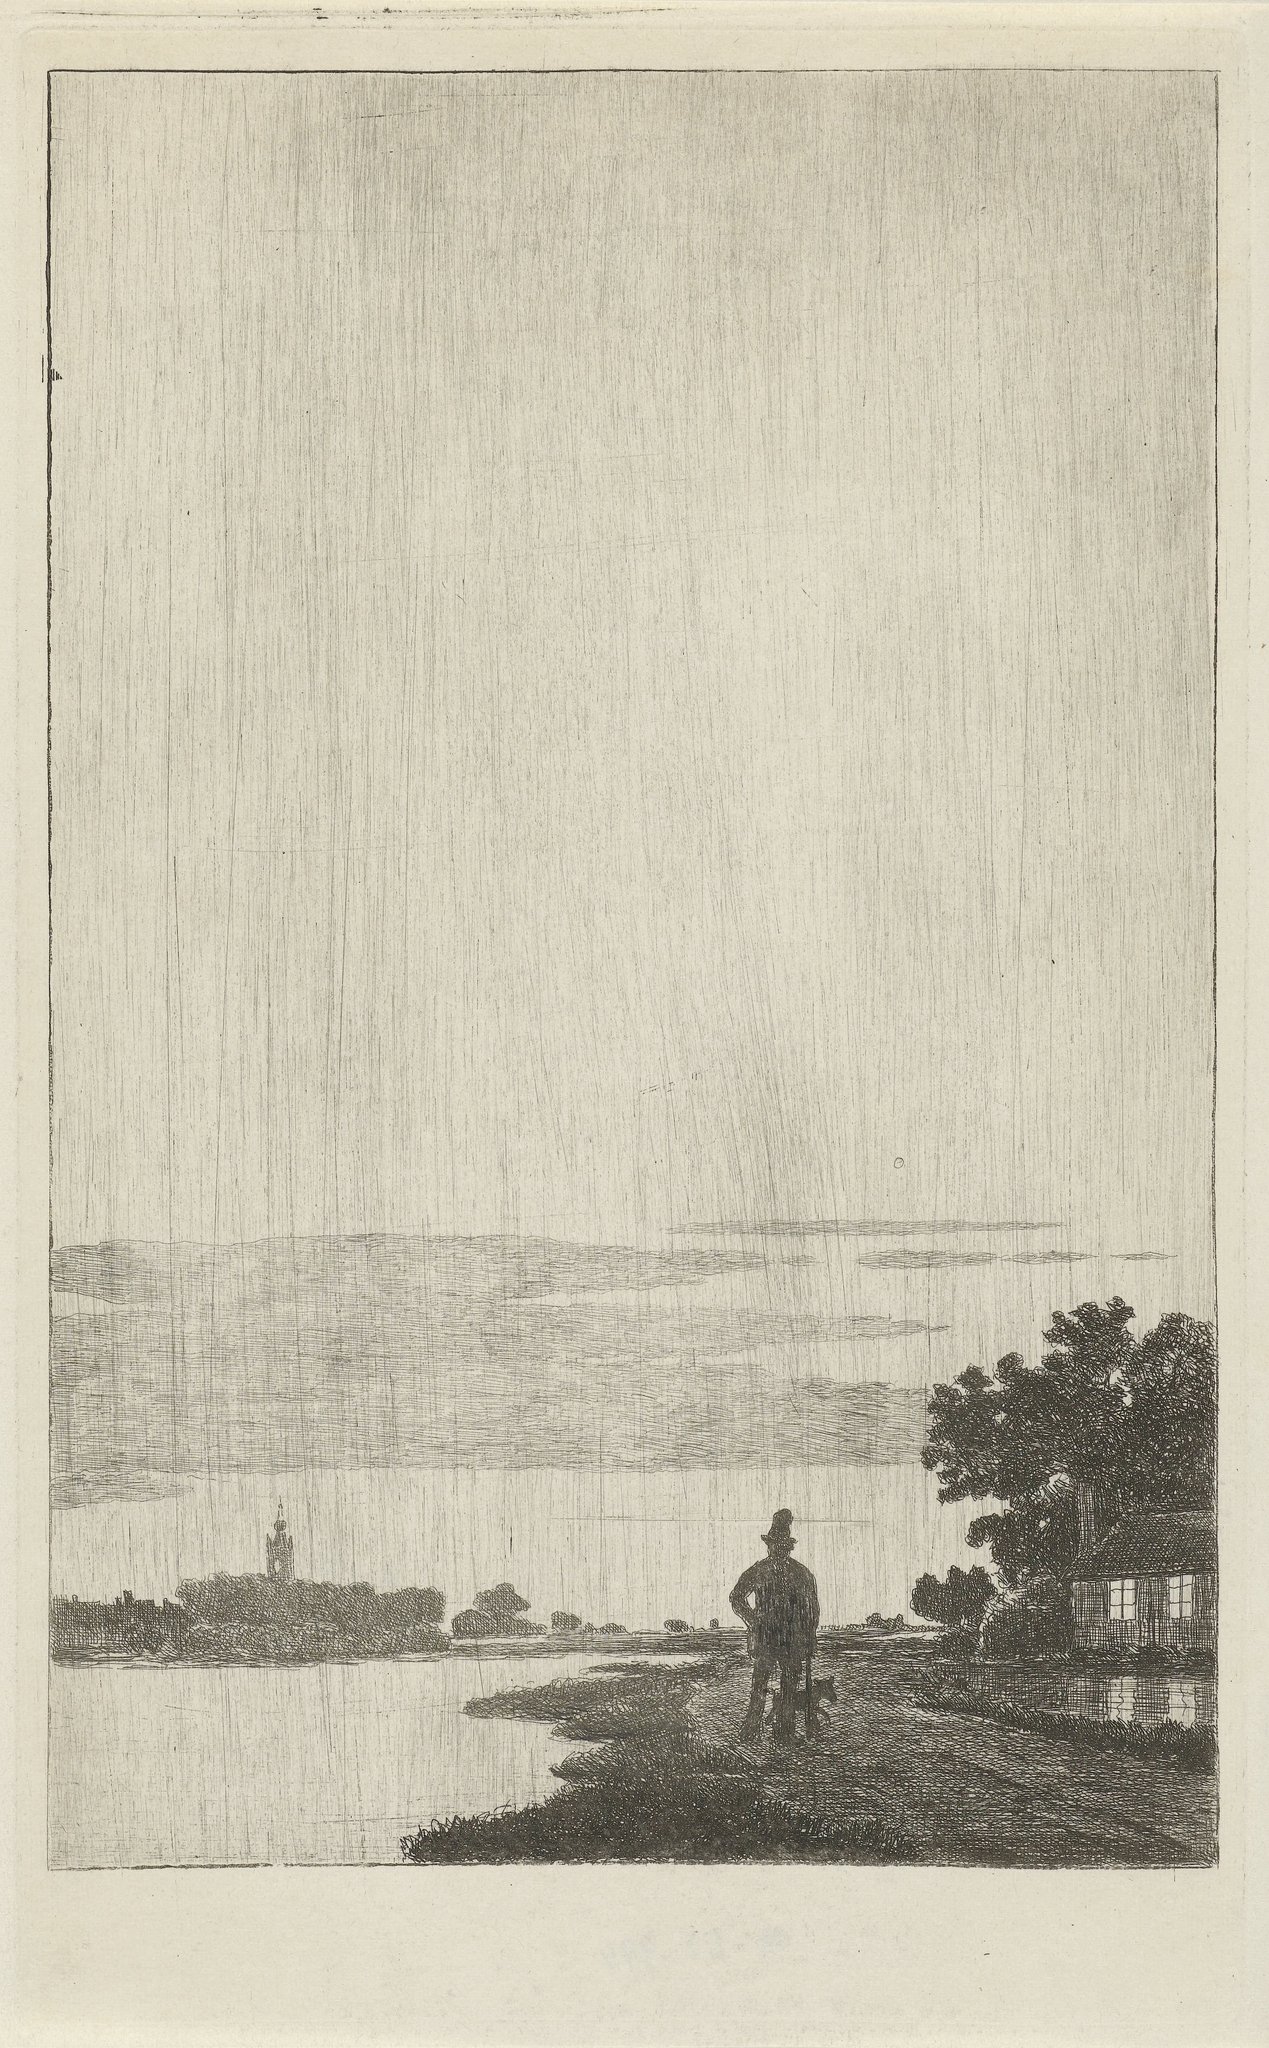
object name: print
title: De komeet van Donati, 1858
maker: cornelis van der griendt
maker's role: draughtsman, painter, print maker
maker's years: 1827-1918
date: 1858-1860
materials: paper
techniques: drypoint, etching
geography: netherlands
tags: river (+ landscape with figures, staffage)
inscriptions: collector's mark: Lugt 2228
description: Op de voorgrond een man met hond bij een rivier. Op de achtergrond links een kerktoren. Voor de komeet.